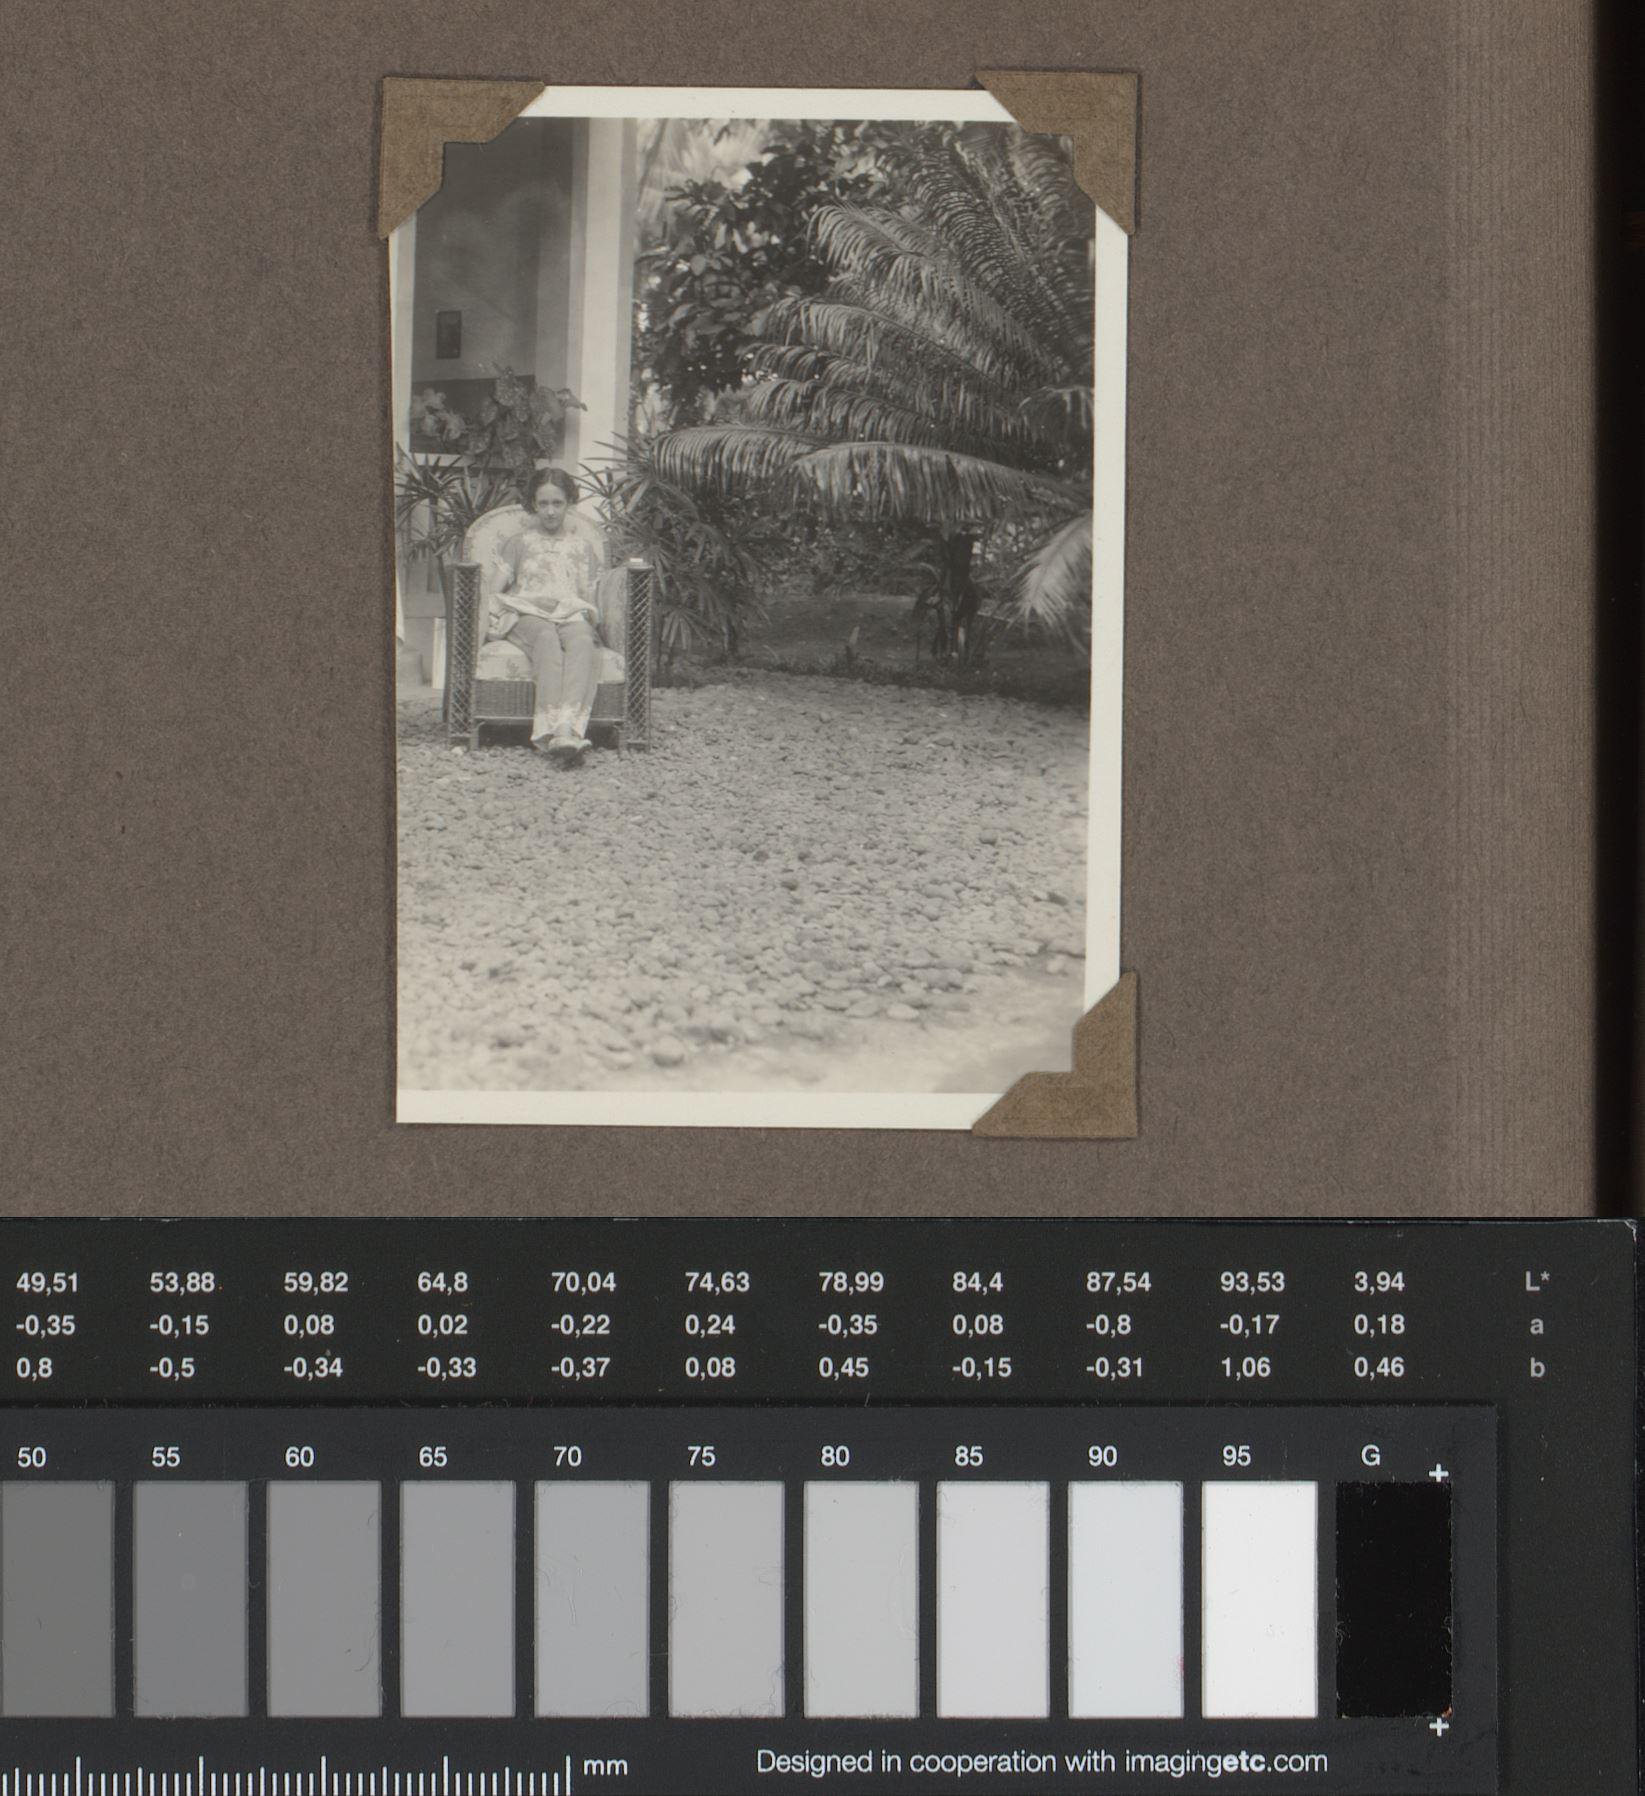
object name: album leaf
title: Dootje van Zijll de Jong in een tuin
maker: Anonymous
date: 1930-1935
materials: paper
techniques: gelatin silver print, snipping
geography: dutch east indies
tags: amsterdam, adult woman, garden, dutch east indies, the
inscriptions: inscription: ‘Ben en ik’